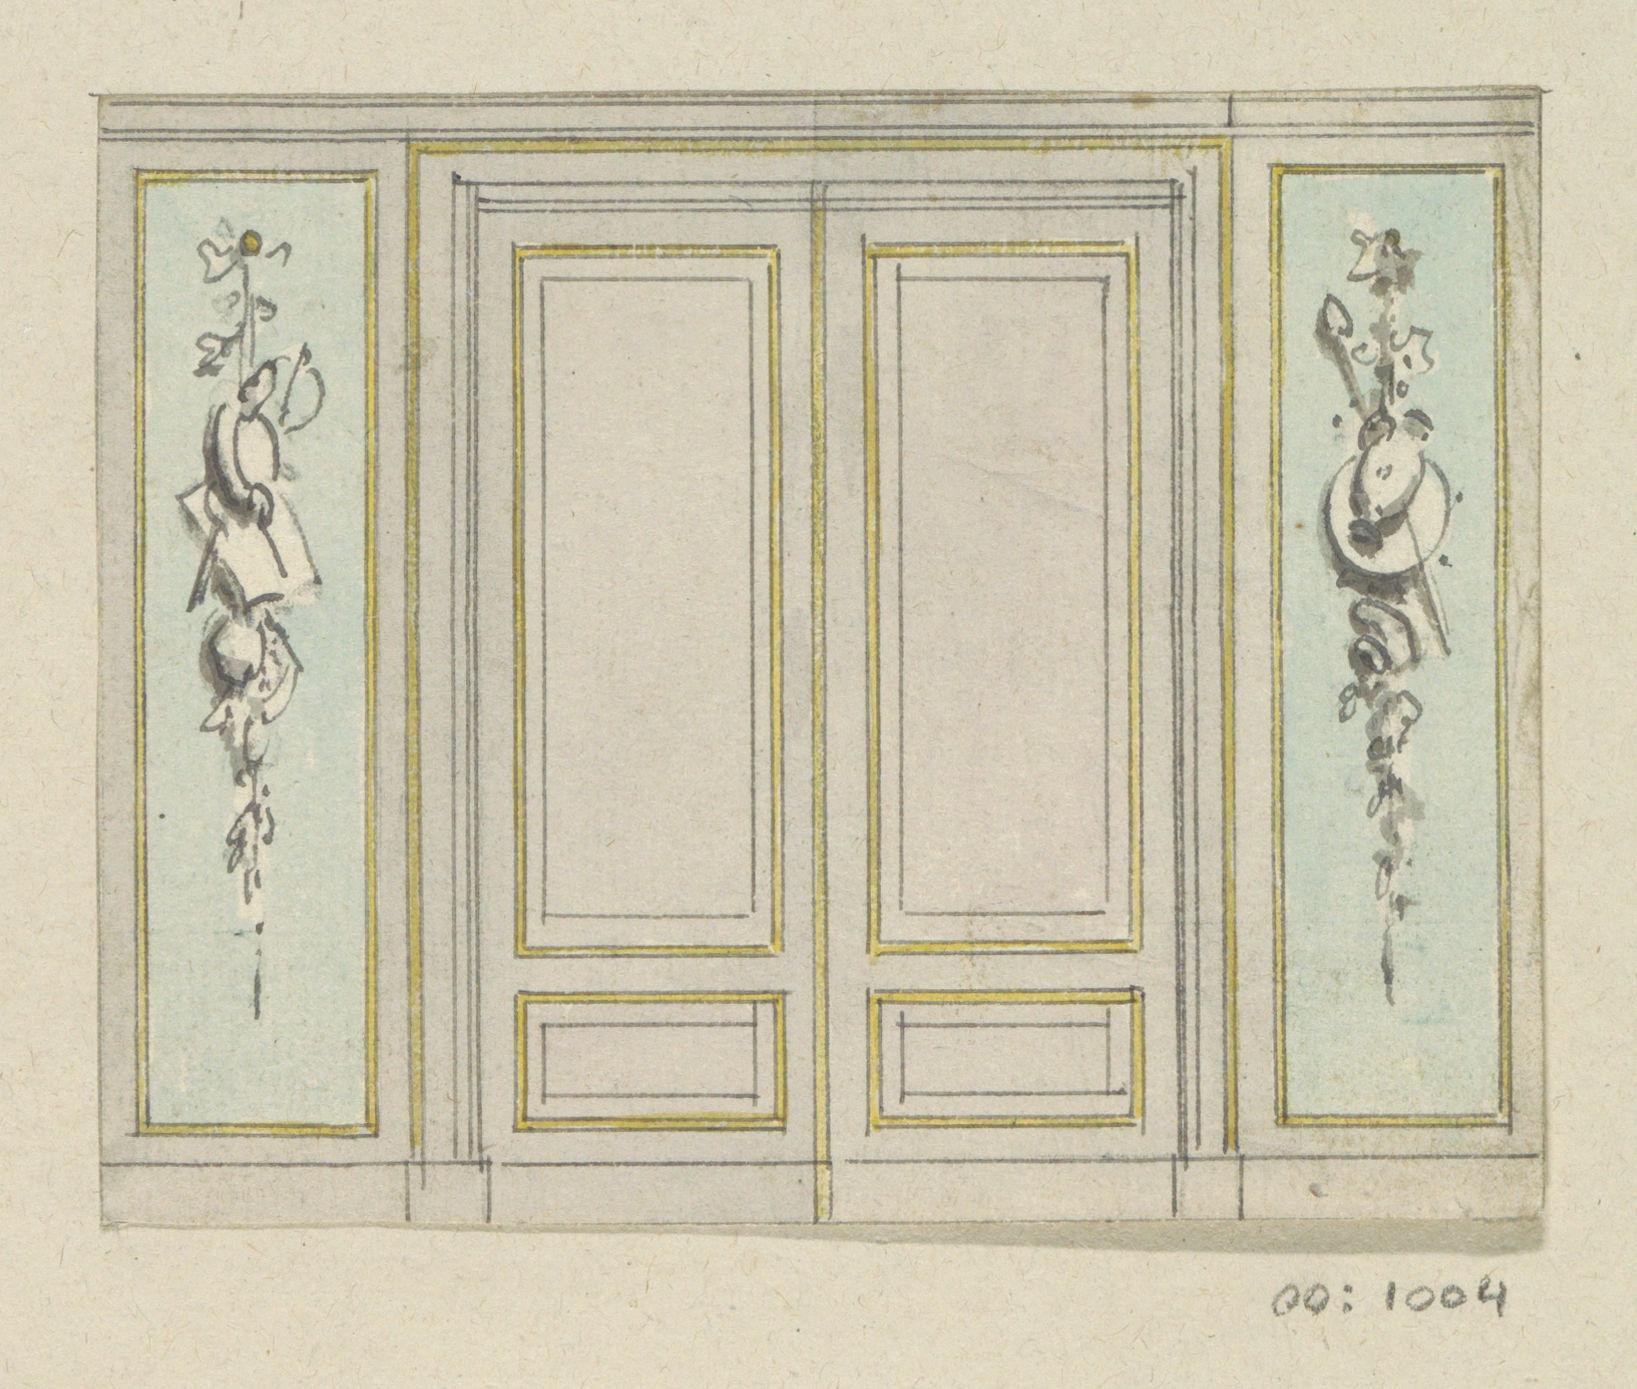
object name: drawing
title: Ontwerptekening voor een kamerwand met deur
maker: jurriaan andriessen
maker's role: draughtsman, painter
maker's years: 1742-1819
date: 1760-1819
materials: paint, paper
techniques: brush, pen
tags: door, wall-covering